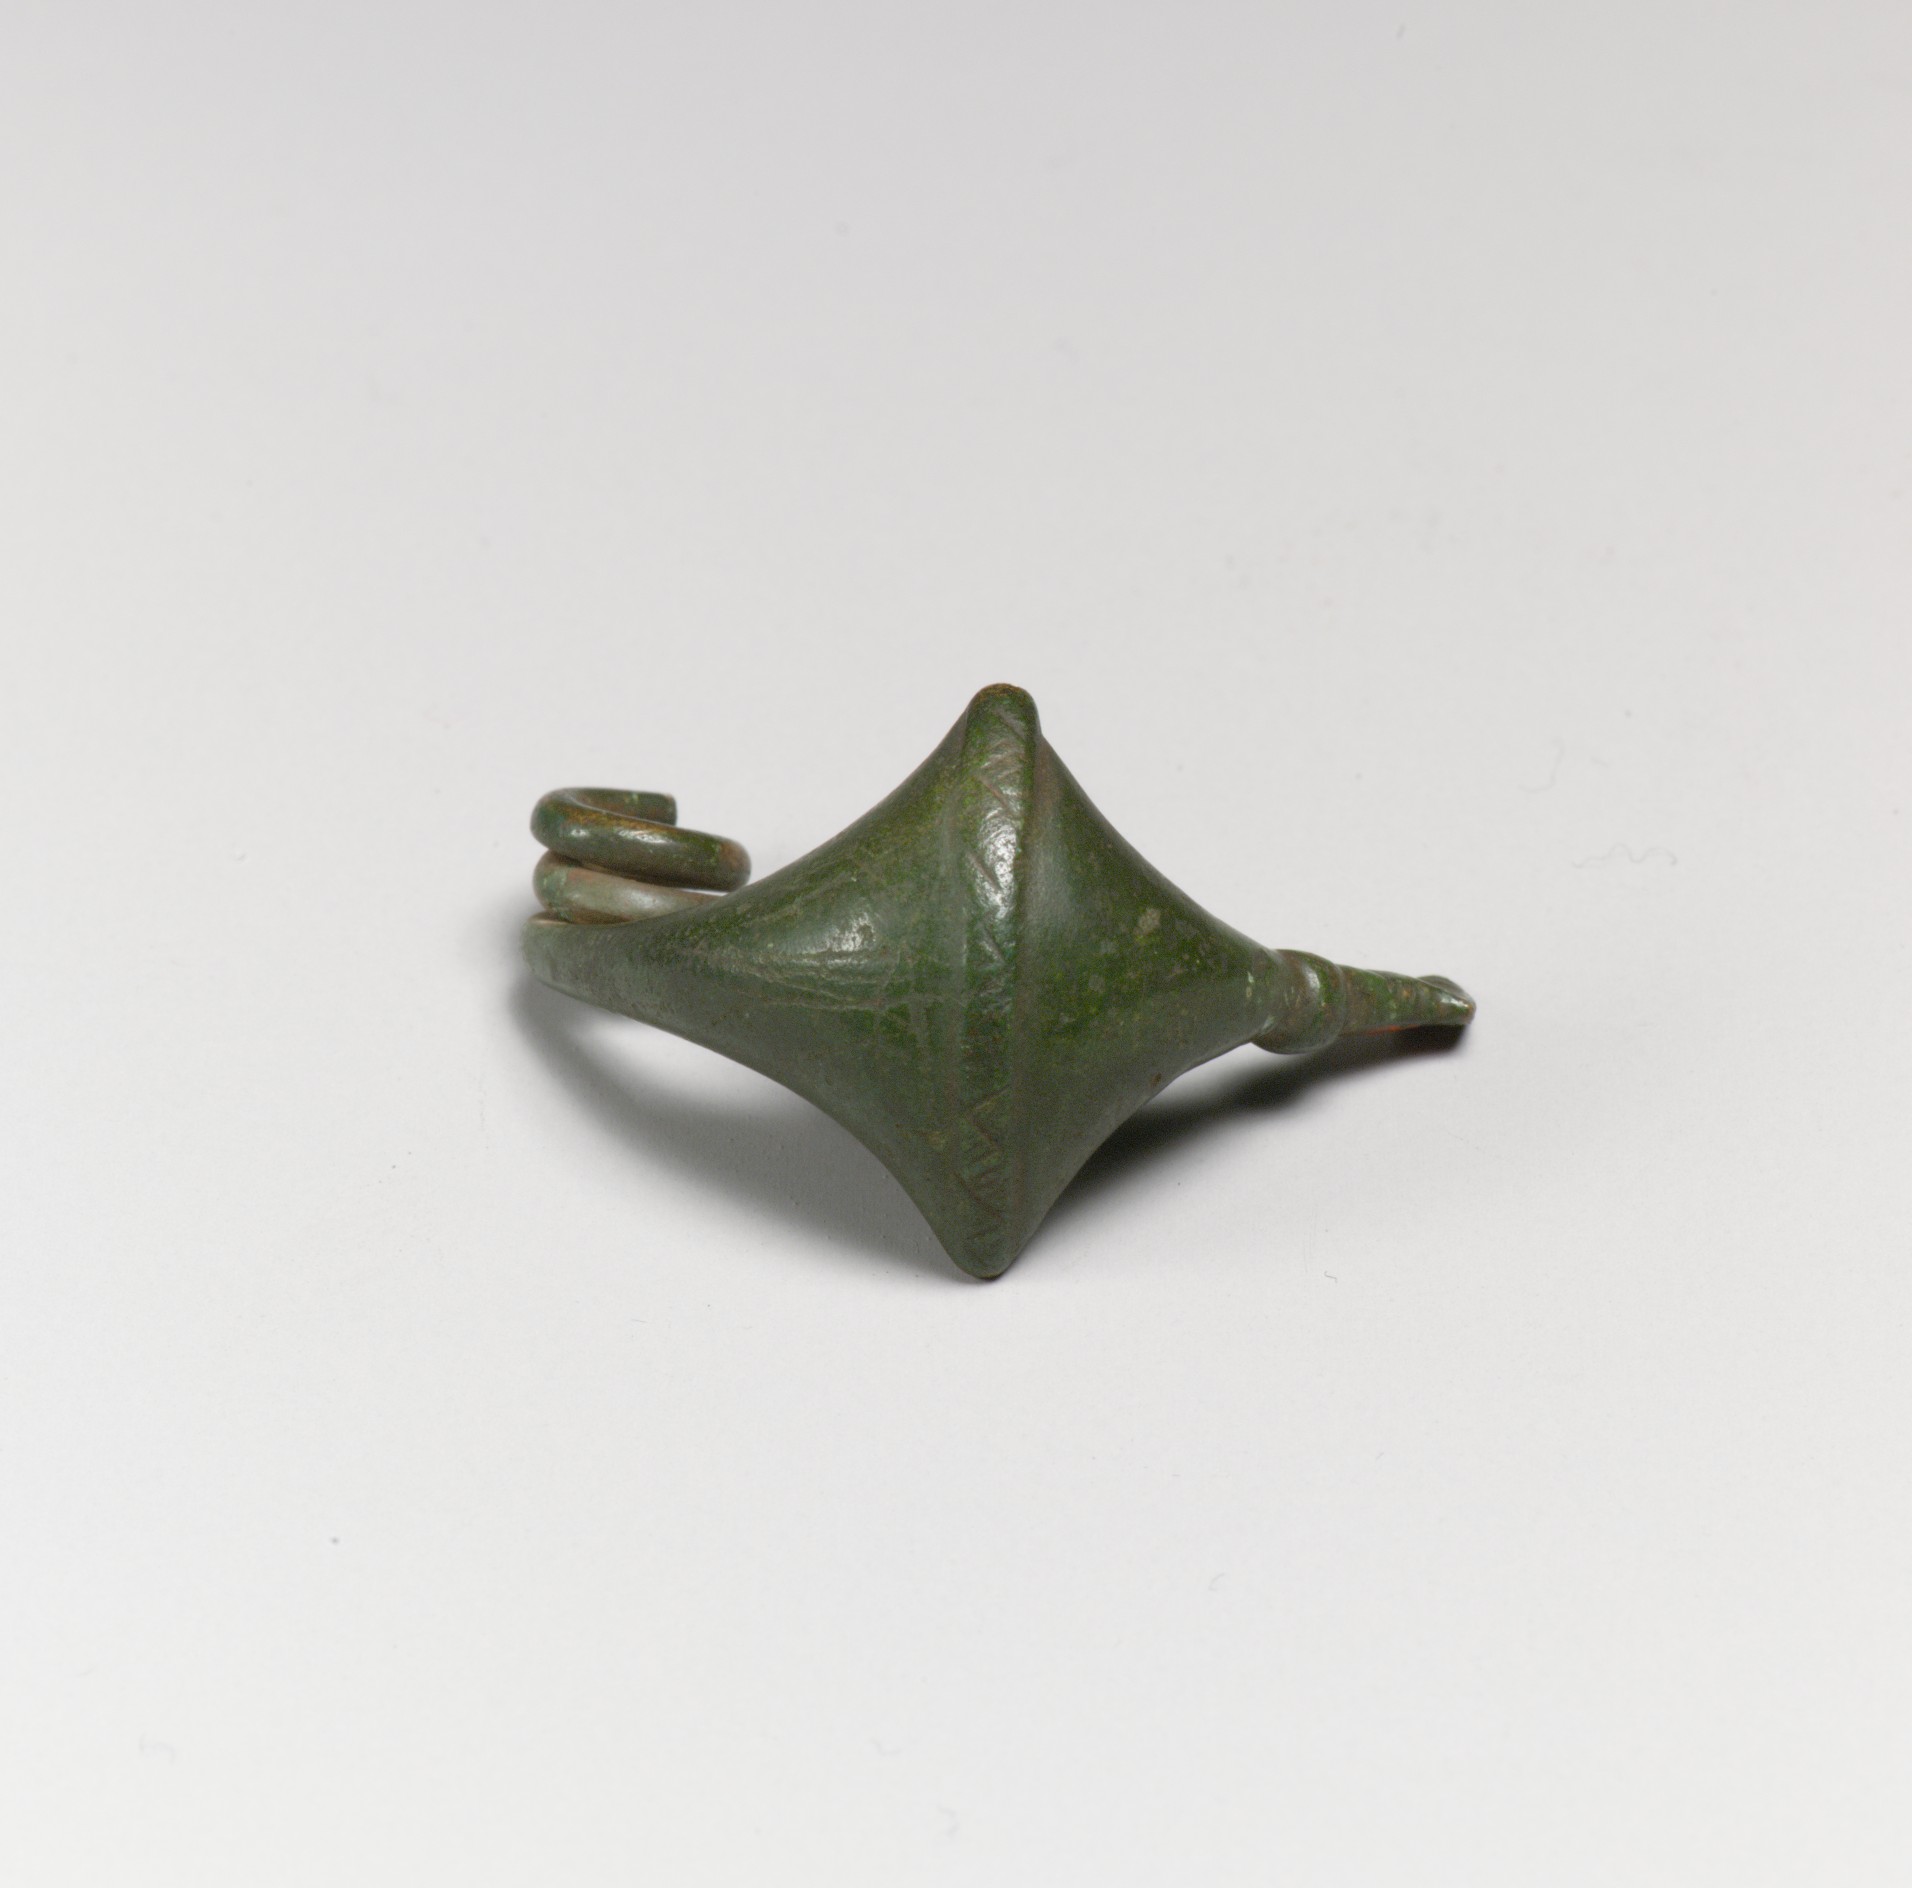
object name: fibula, boat shaped type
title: Fibula, boat-shaped type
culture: italic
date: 800-501 BCE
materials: bronze